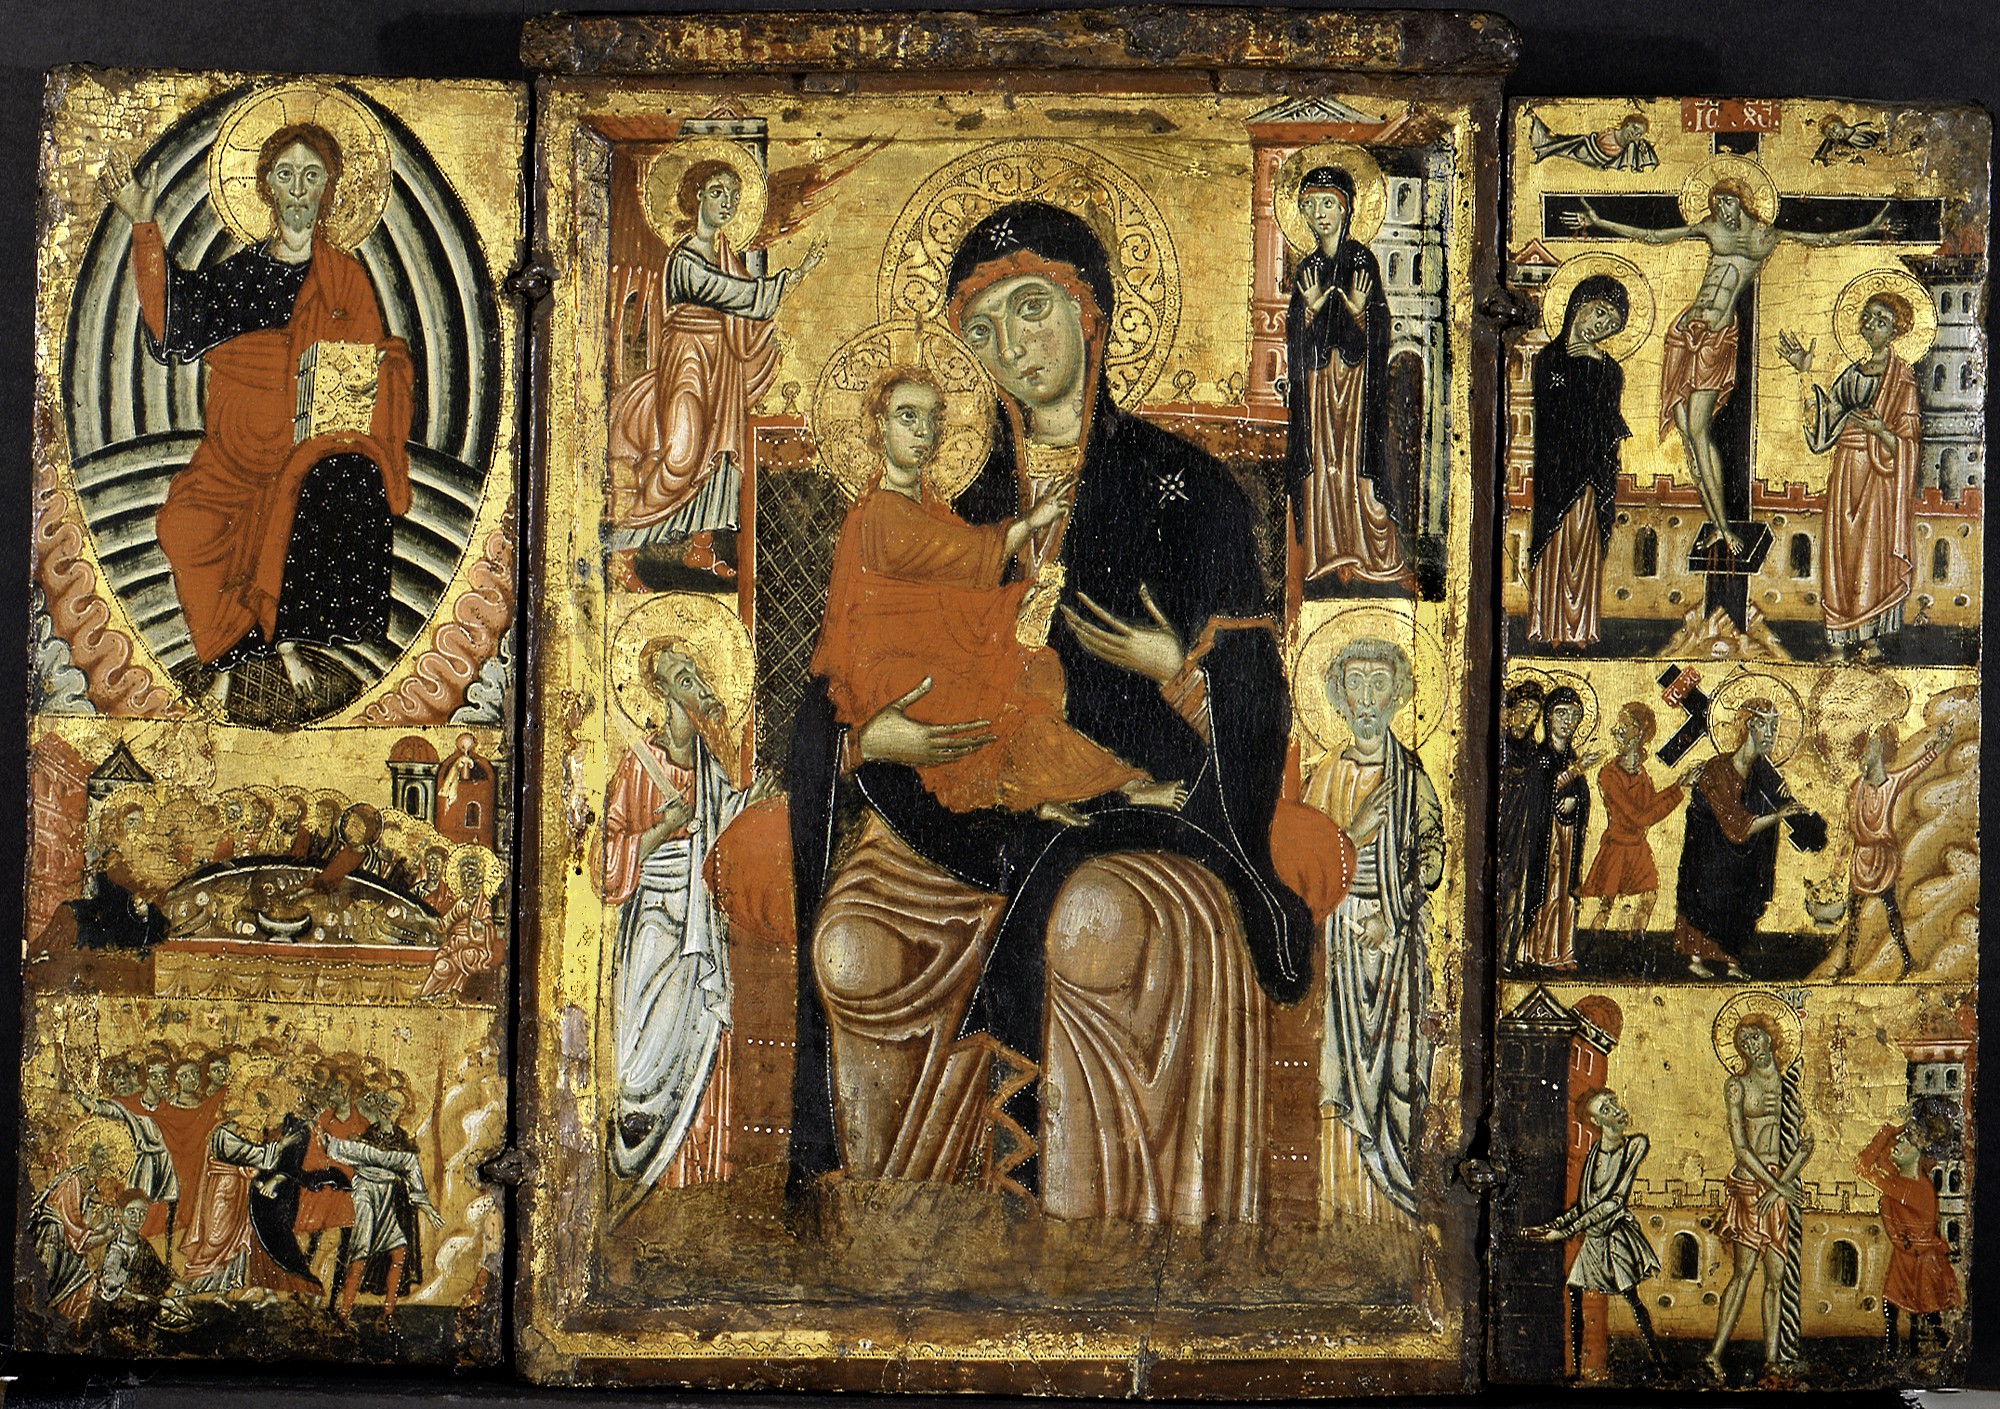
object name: painting, triptych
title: Madonna and Child Enthroned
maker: master of the magdalen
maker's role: artist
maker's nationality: italian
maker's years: 1265-1295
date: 1265-1295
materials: gold leaf, paint, wood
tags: christ,madonna and child,bearing the cross,crucifixion,last supper,saints,flagellation